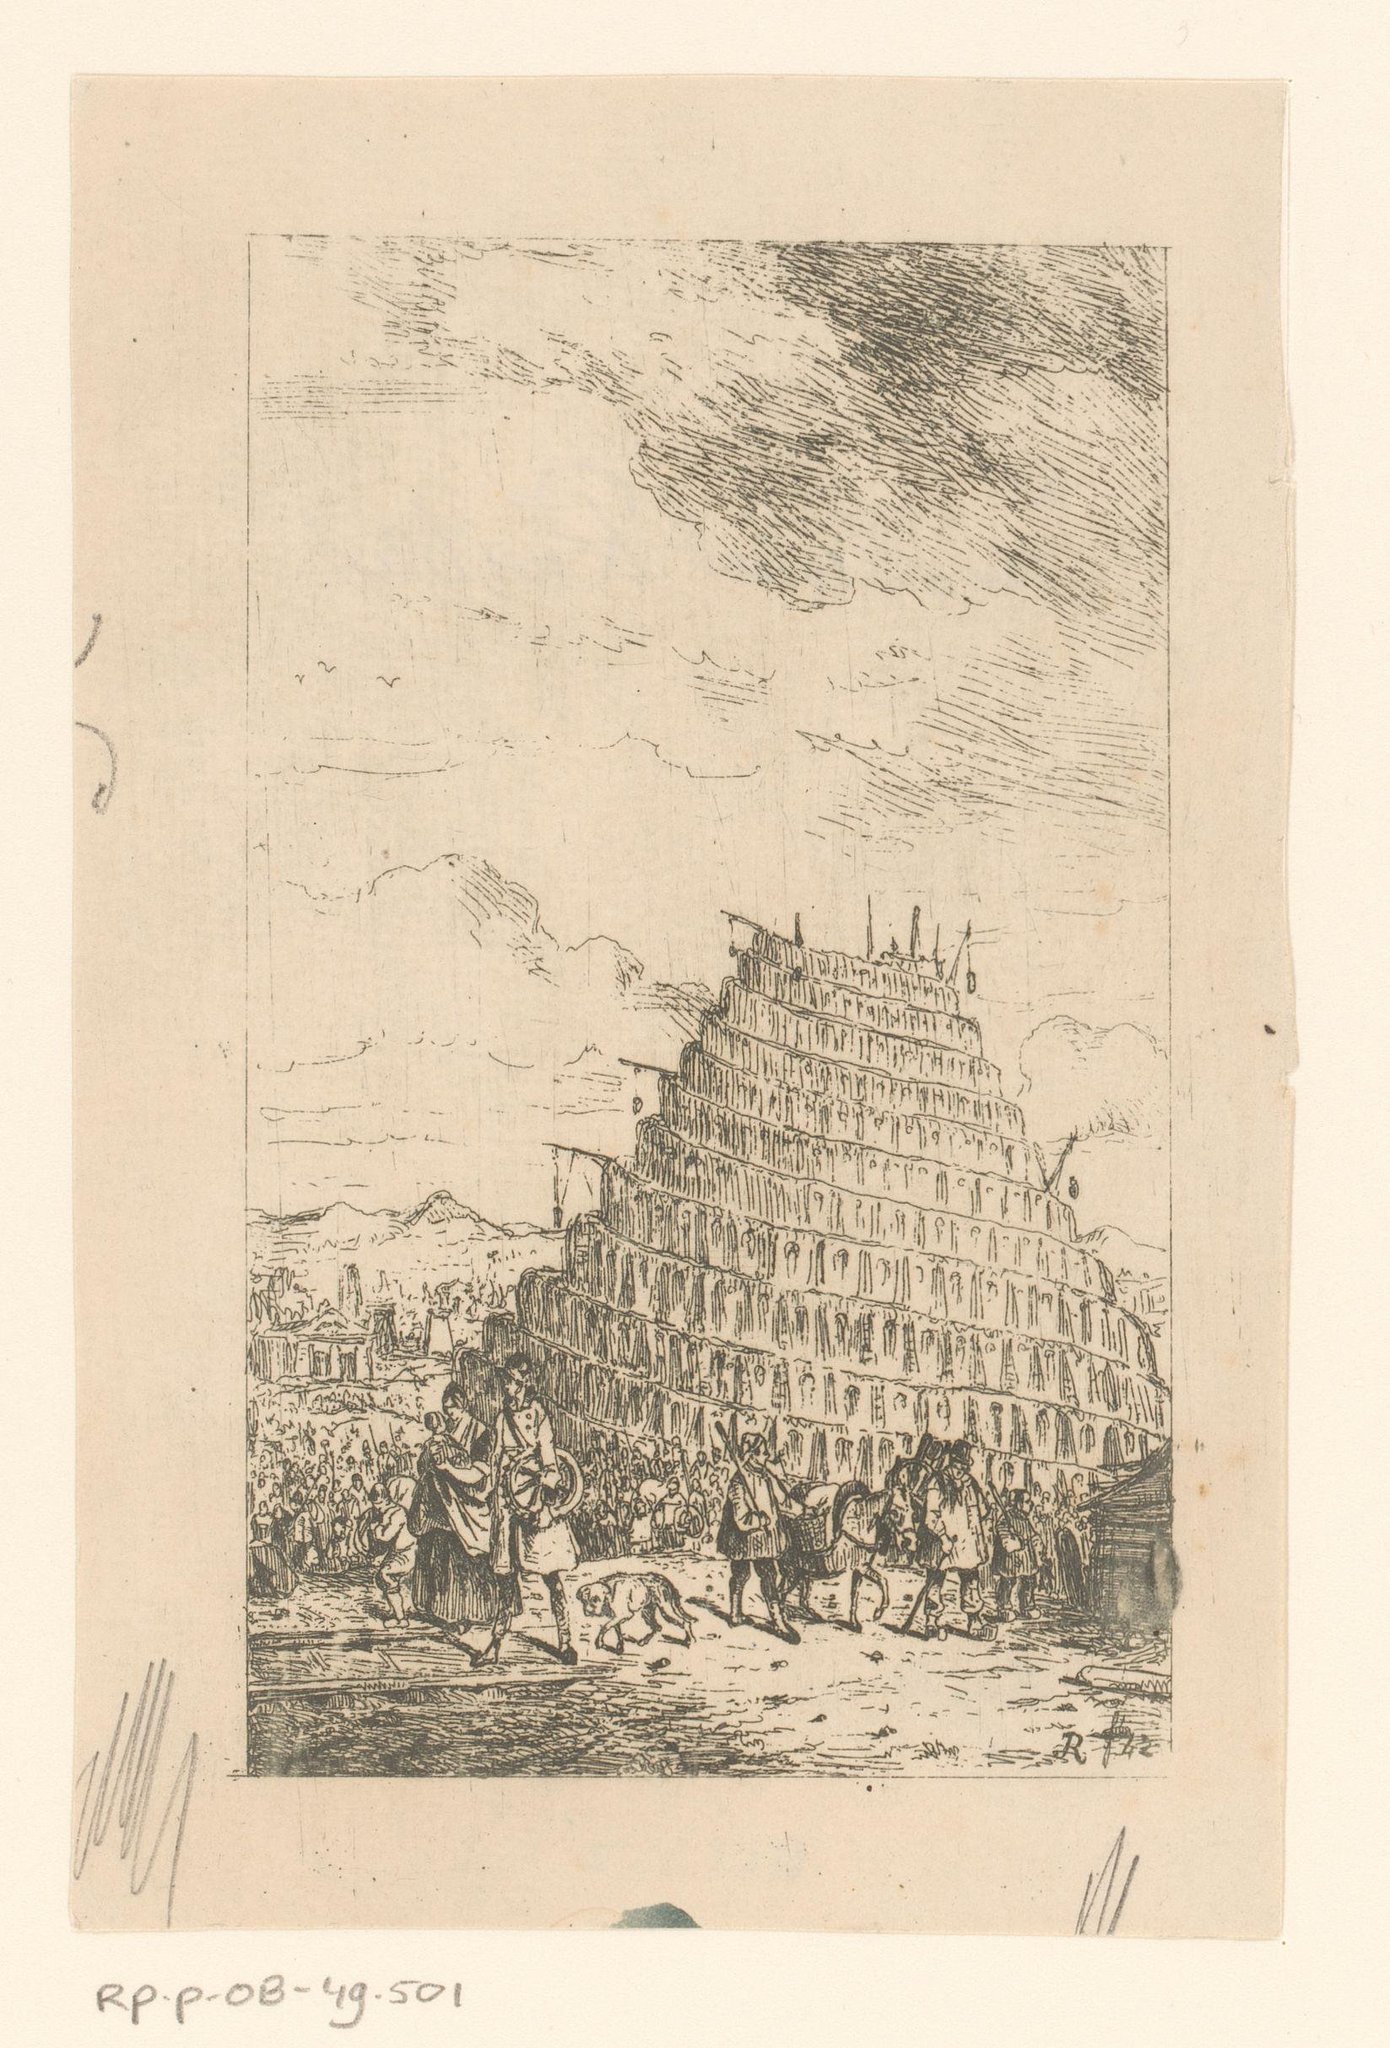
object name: print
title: Toren van Babel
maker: jean michel ruyten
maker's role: draughtsman, print maker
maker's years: 1813-1881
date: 1842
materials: paper, pencil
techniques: etching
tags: the tower of babel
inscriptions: collector's mark: Lugt 2228